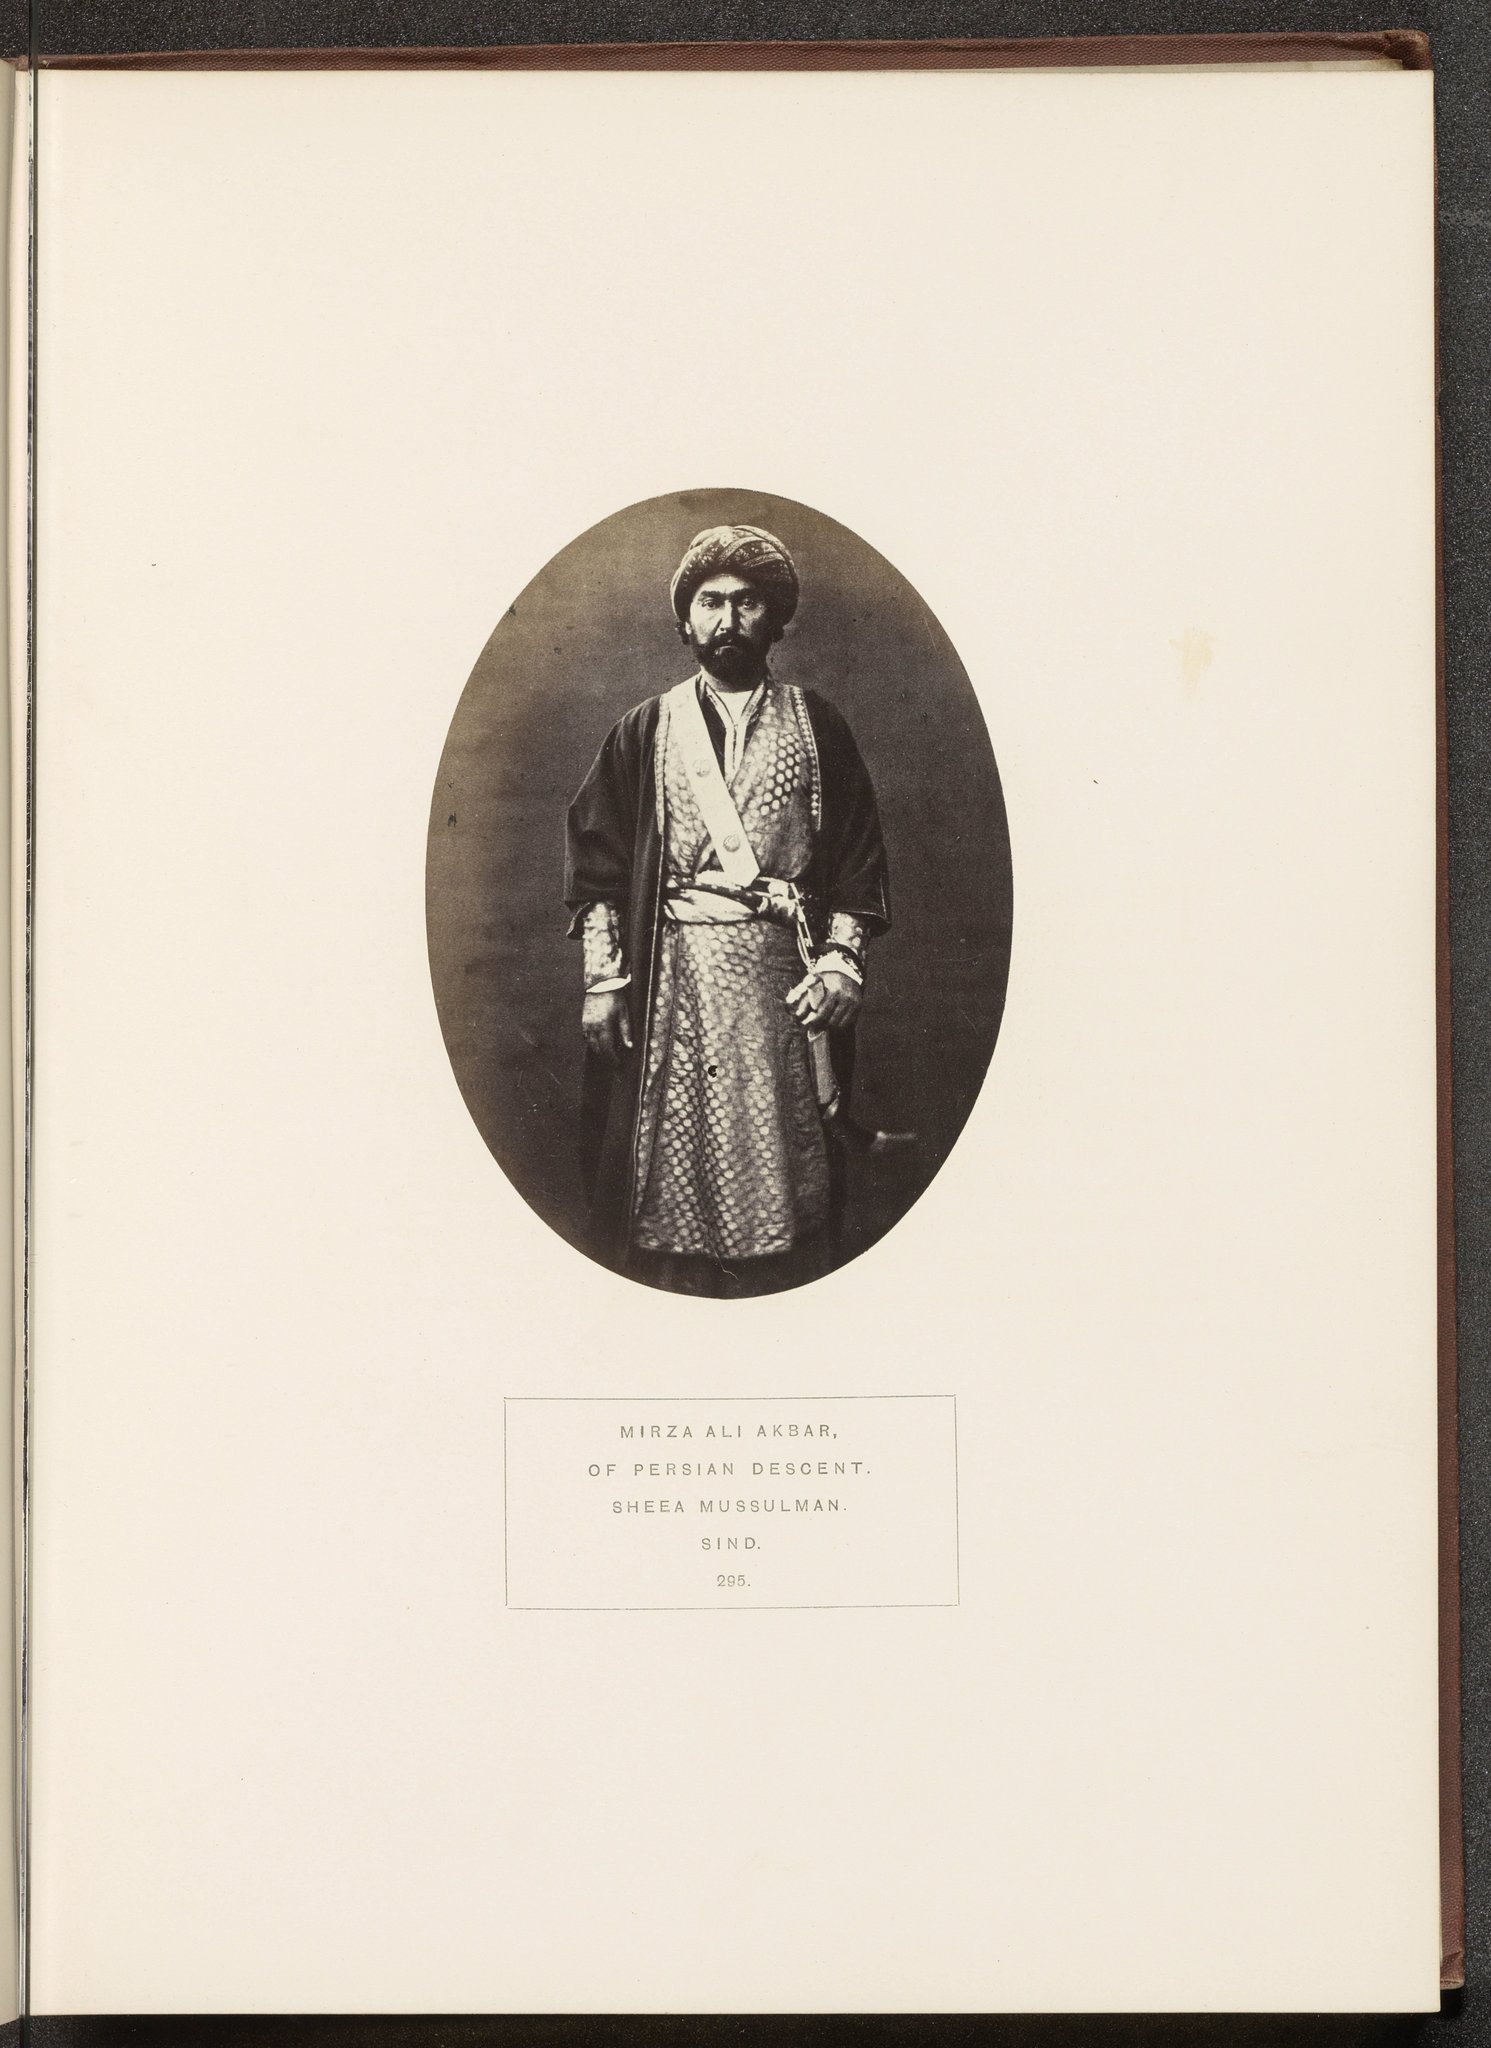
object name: photograph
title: Portrait of Mirza Ali Akbar, a nobleman of Persian descent, Sindh, Pakistan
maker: henry charles baskerville tanner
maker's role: fotograaf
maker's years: 1835-1898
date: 1862-1872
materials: photographic support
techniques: albumen print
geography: sindh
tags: prince, head-gear: turban, human races; peoples; nationalities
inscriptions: inscription: ‘MIRZA ALI AKBAR, OF PERSIAN DESCENT./ SHEEA MUSSULMAN./ SIND.’, number: ‘295.’